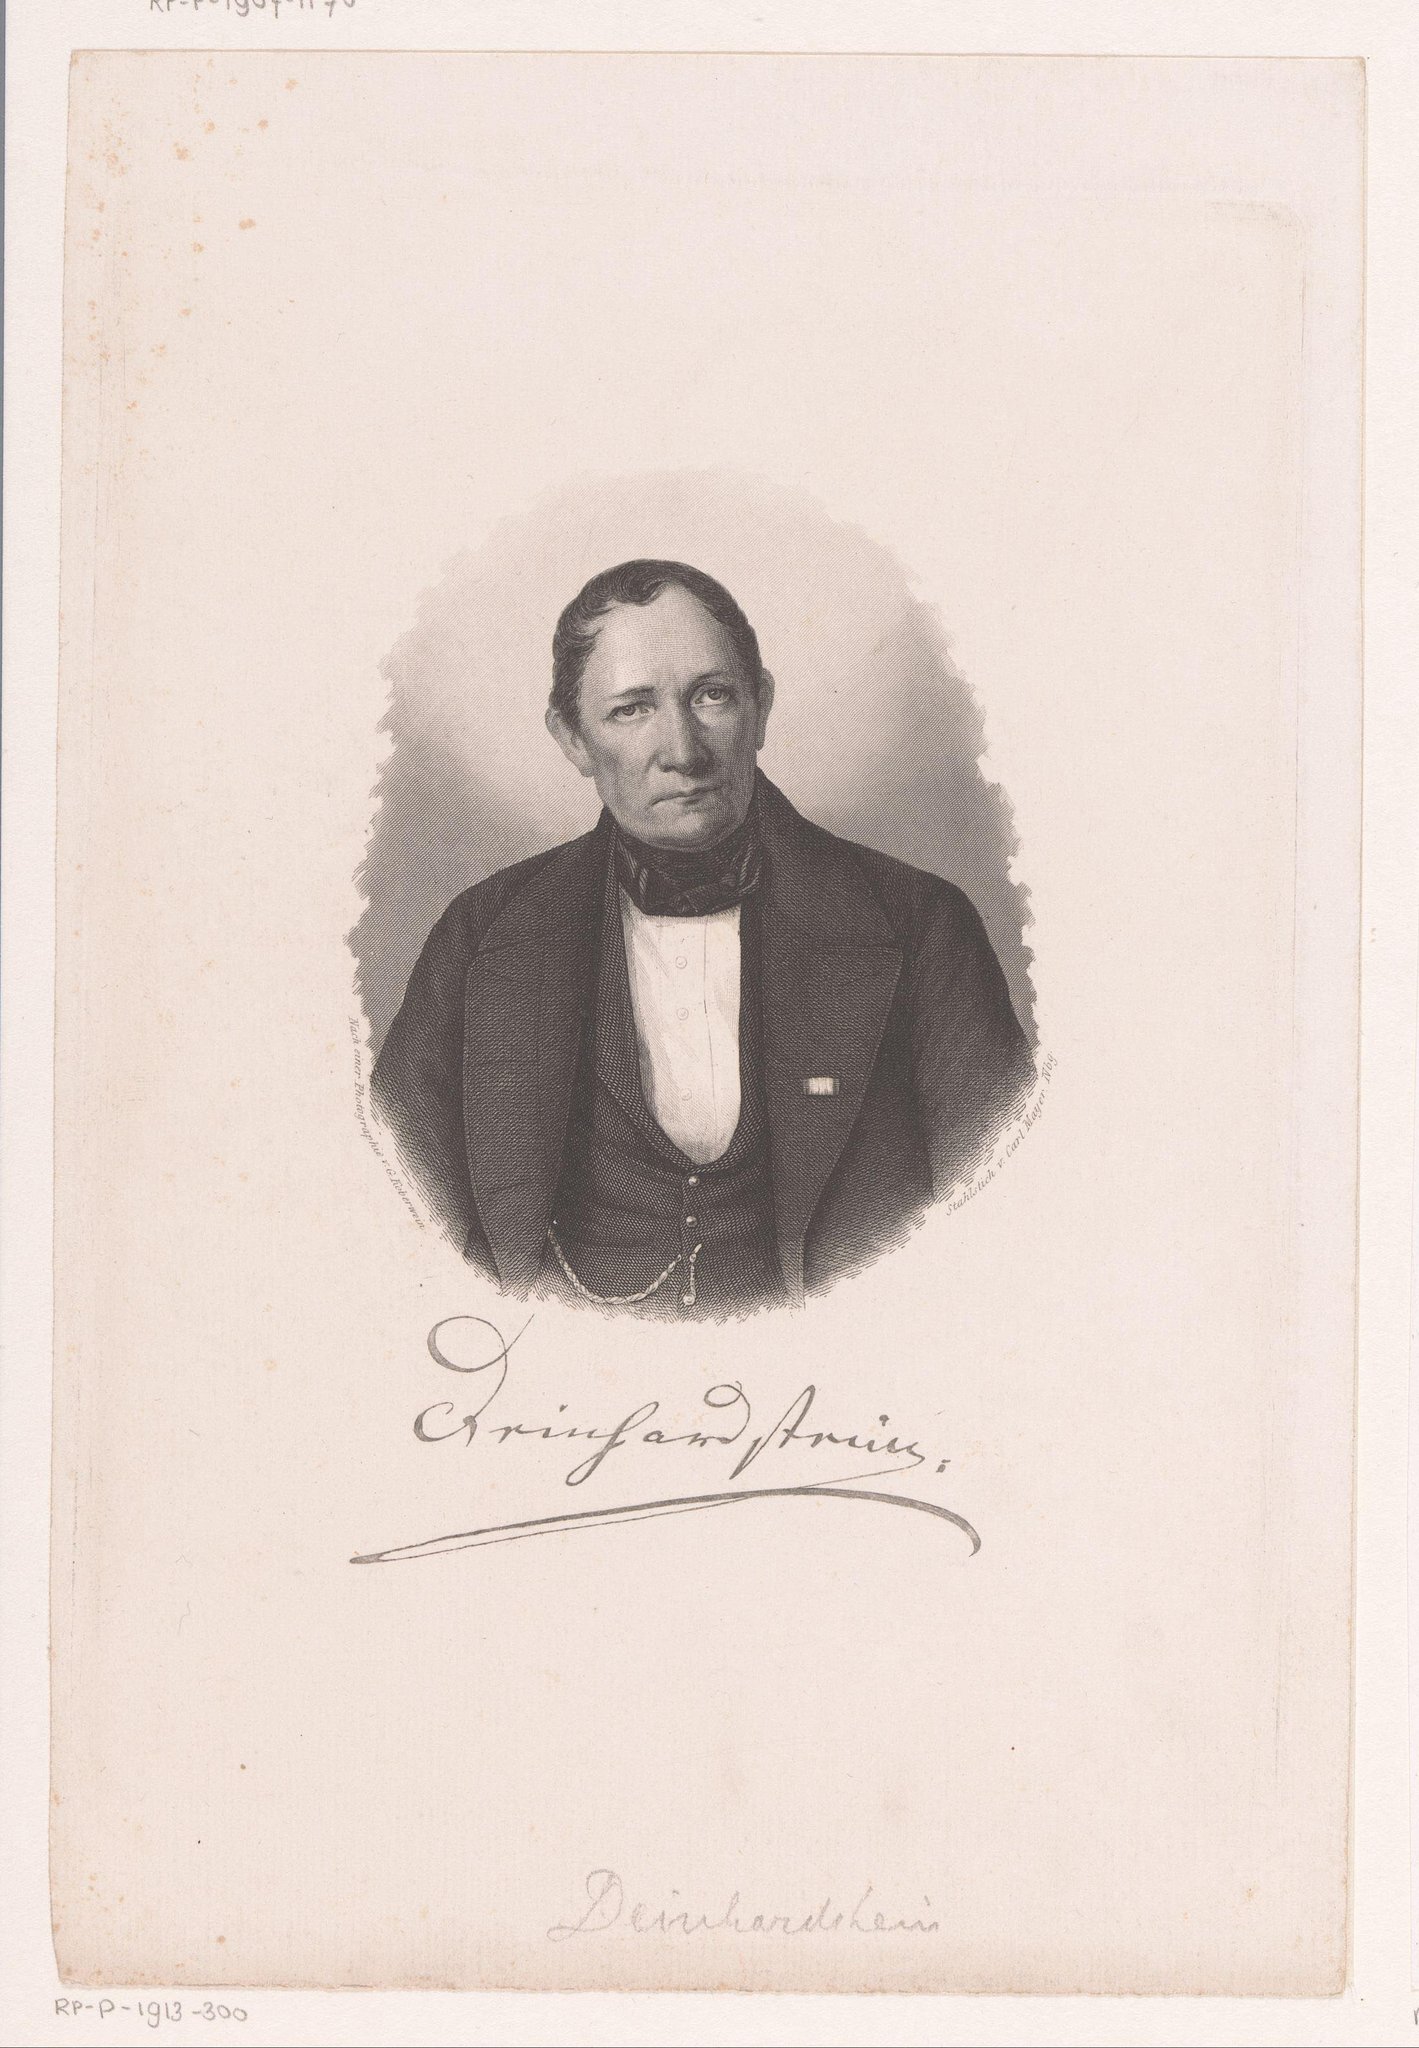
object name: print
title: Portret van een onbekende man, genaamd Drinhardstein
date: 1808-1868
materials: paper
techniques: engraving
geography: nuremberg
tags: historical persons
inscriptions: collector's mark: Lugt 2228